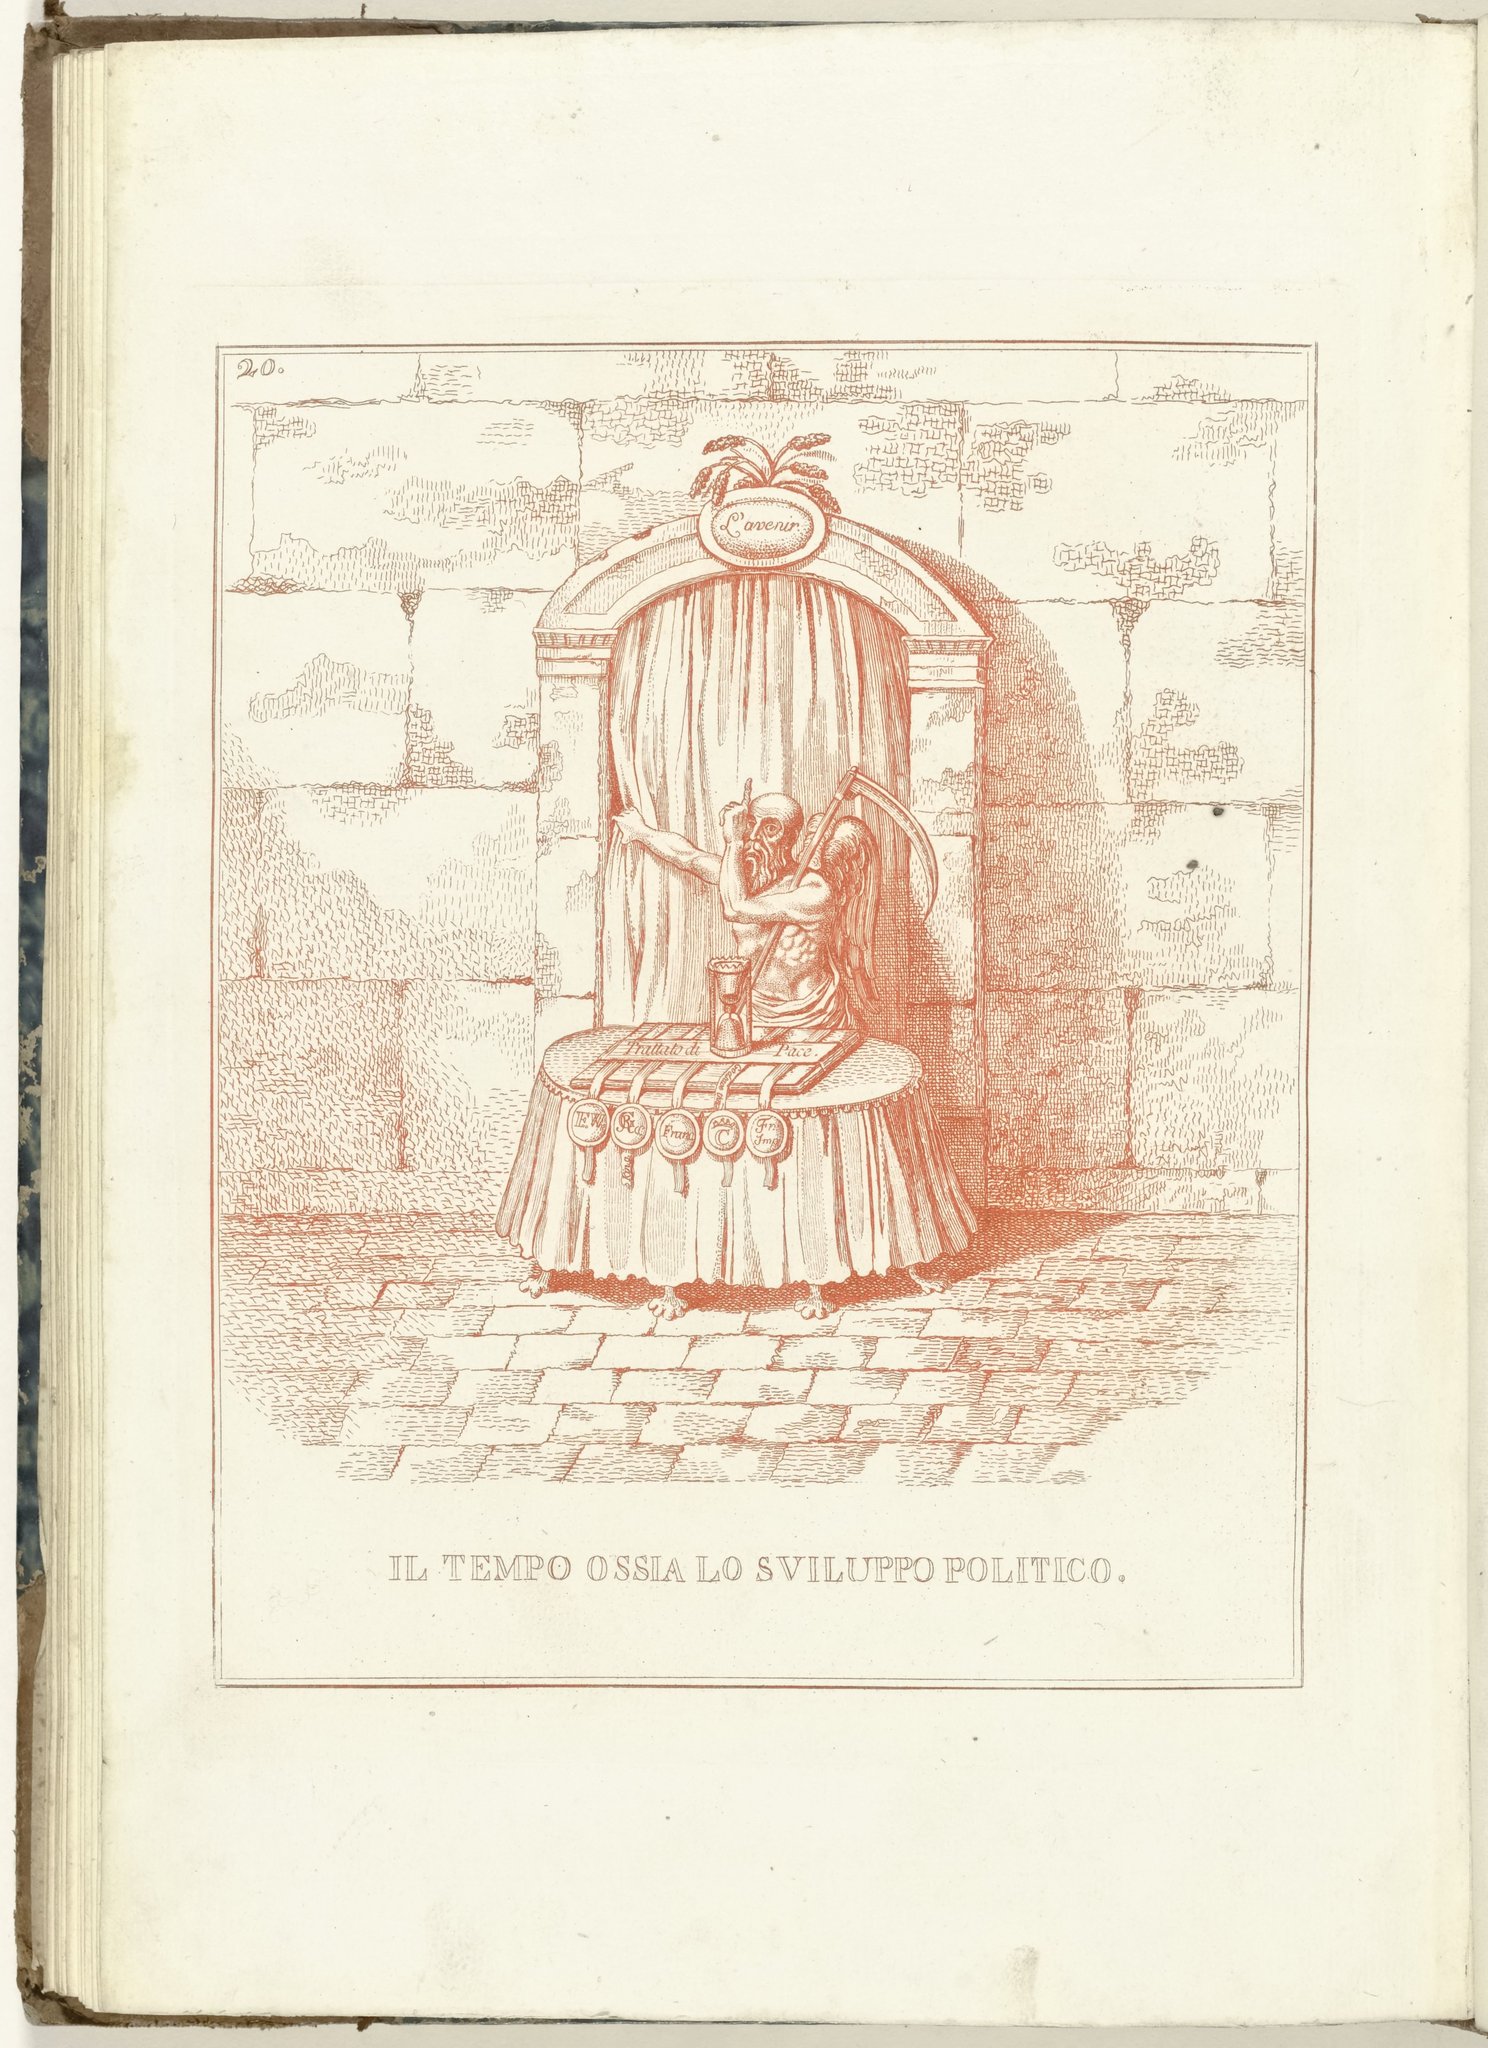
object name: print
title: Vader Tijd voor de poort naar de toekomst, 1795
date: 1799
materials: paper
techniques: engraving, etching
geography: venice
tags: signing of peace treaty, concluding the peace, father time, man with wings and scythe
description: Titelpagina voor de in boekvorm uitgegeven serie van twintig spotprenten op de Provisionele Representanten van het Volk van Holland en de Bataafse Republiek in het algemeen in het jaar 1795. Kopieën gemaakt en uitgegeven in Ventië in 1799, Elke prent wordt gevolgd door een tekstblad met een verklaring in het Frans en de vertaling in het Italiaans gevolgd door een opmerking door de vertaler. Naar de oorspronkelijke reeks met de serietitel 'Hollandia Regenerata' met 20 prenten waarschijnlijk door James Gillray geëtst en waarschijnlijk uitgegeven in Londen door William Humphrey in 1795.